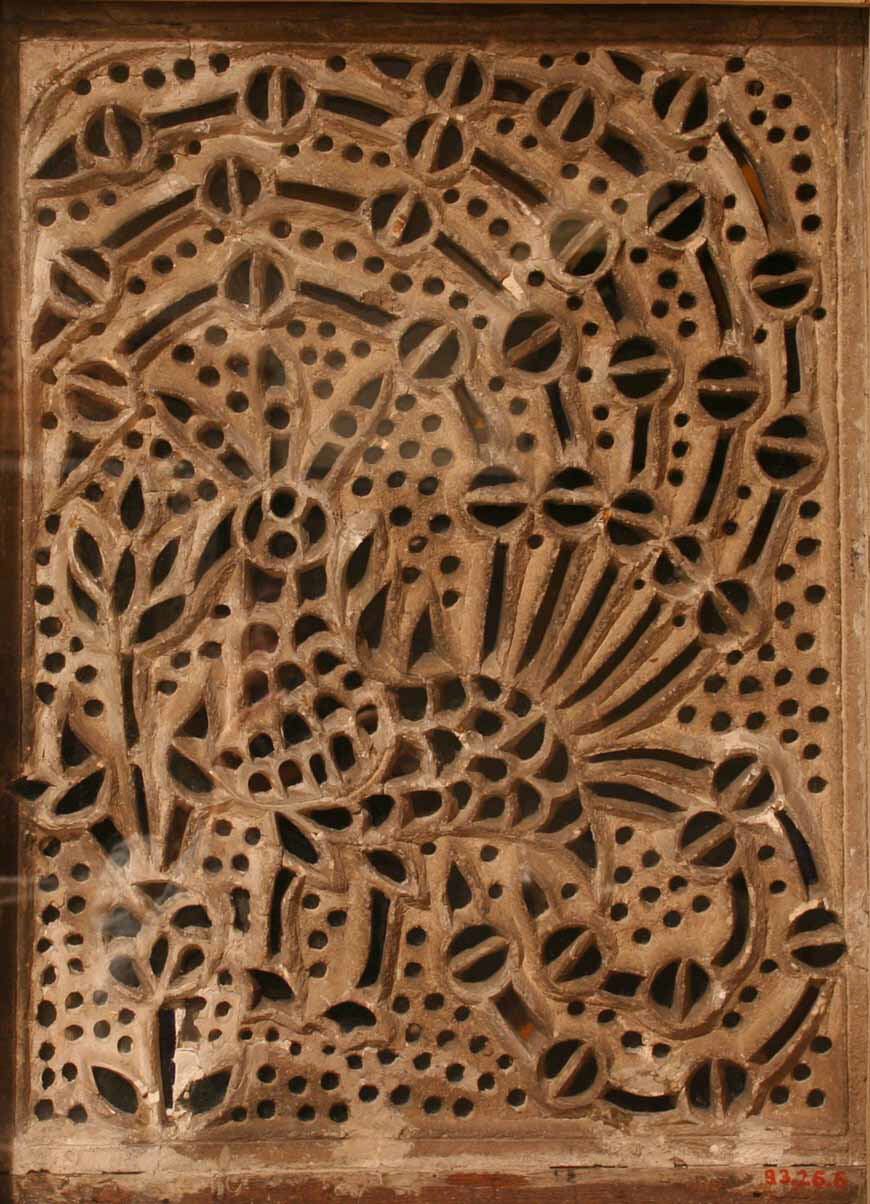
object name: window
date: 1701-1800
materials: gypsum, glass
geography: egypt or syria